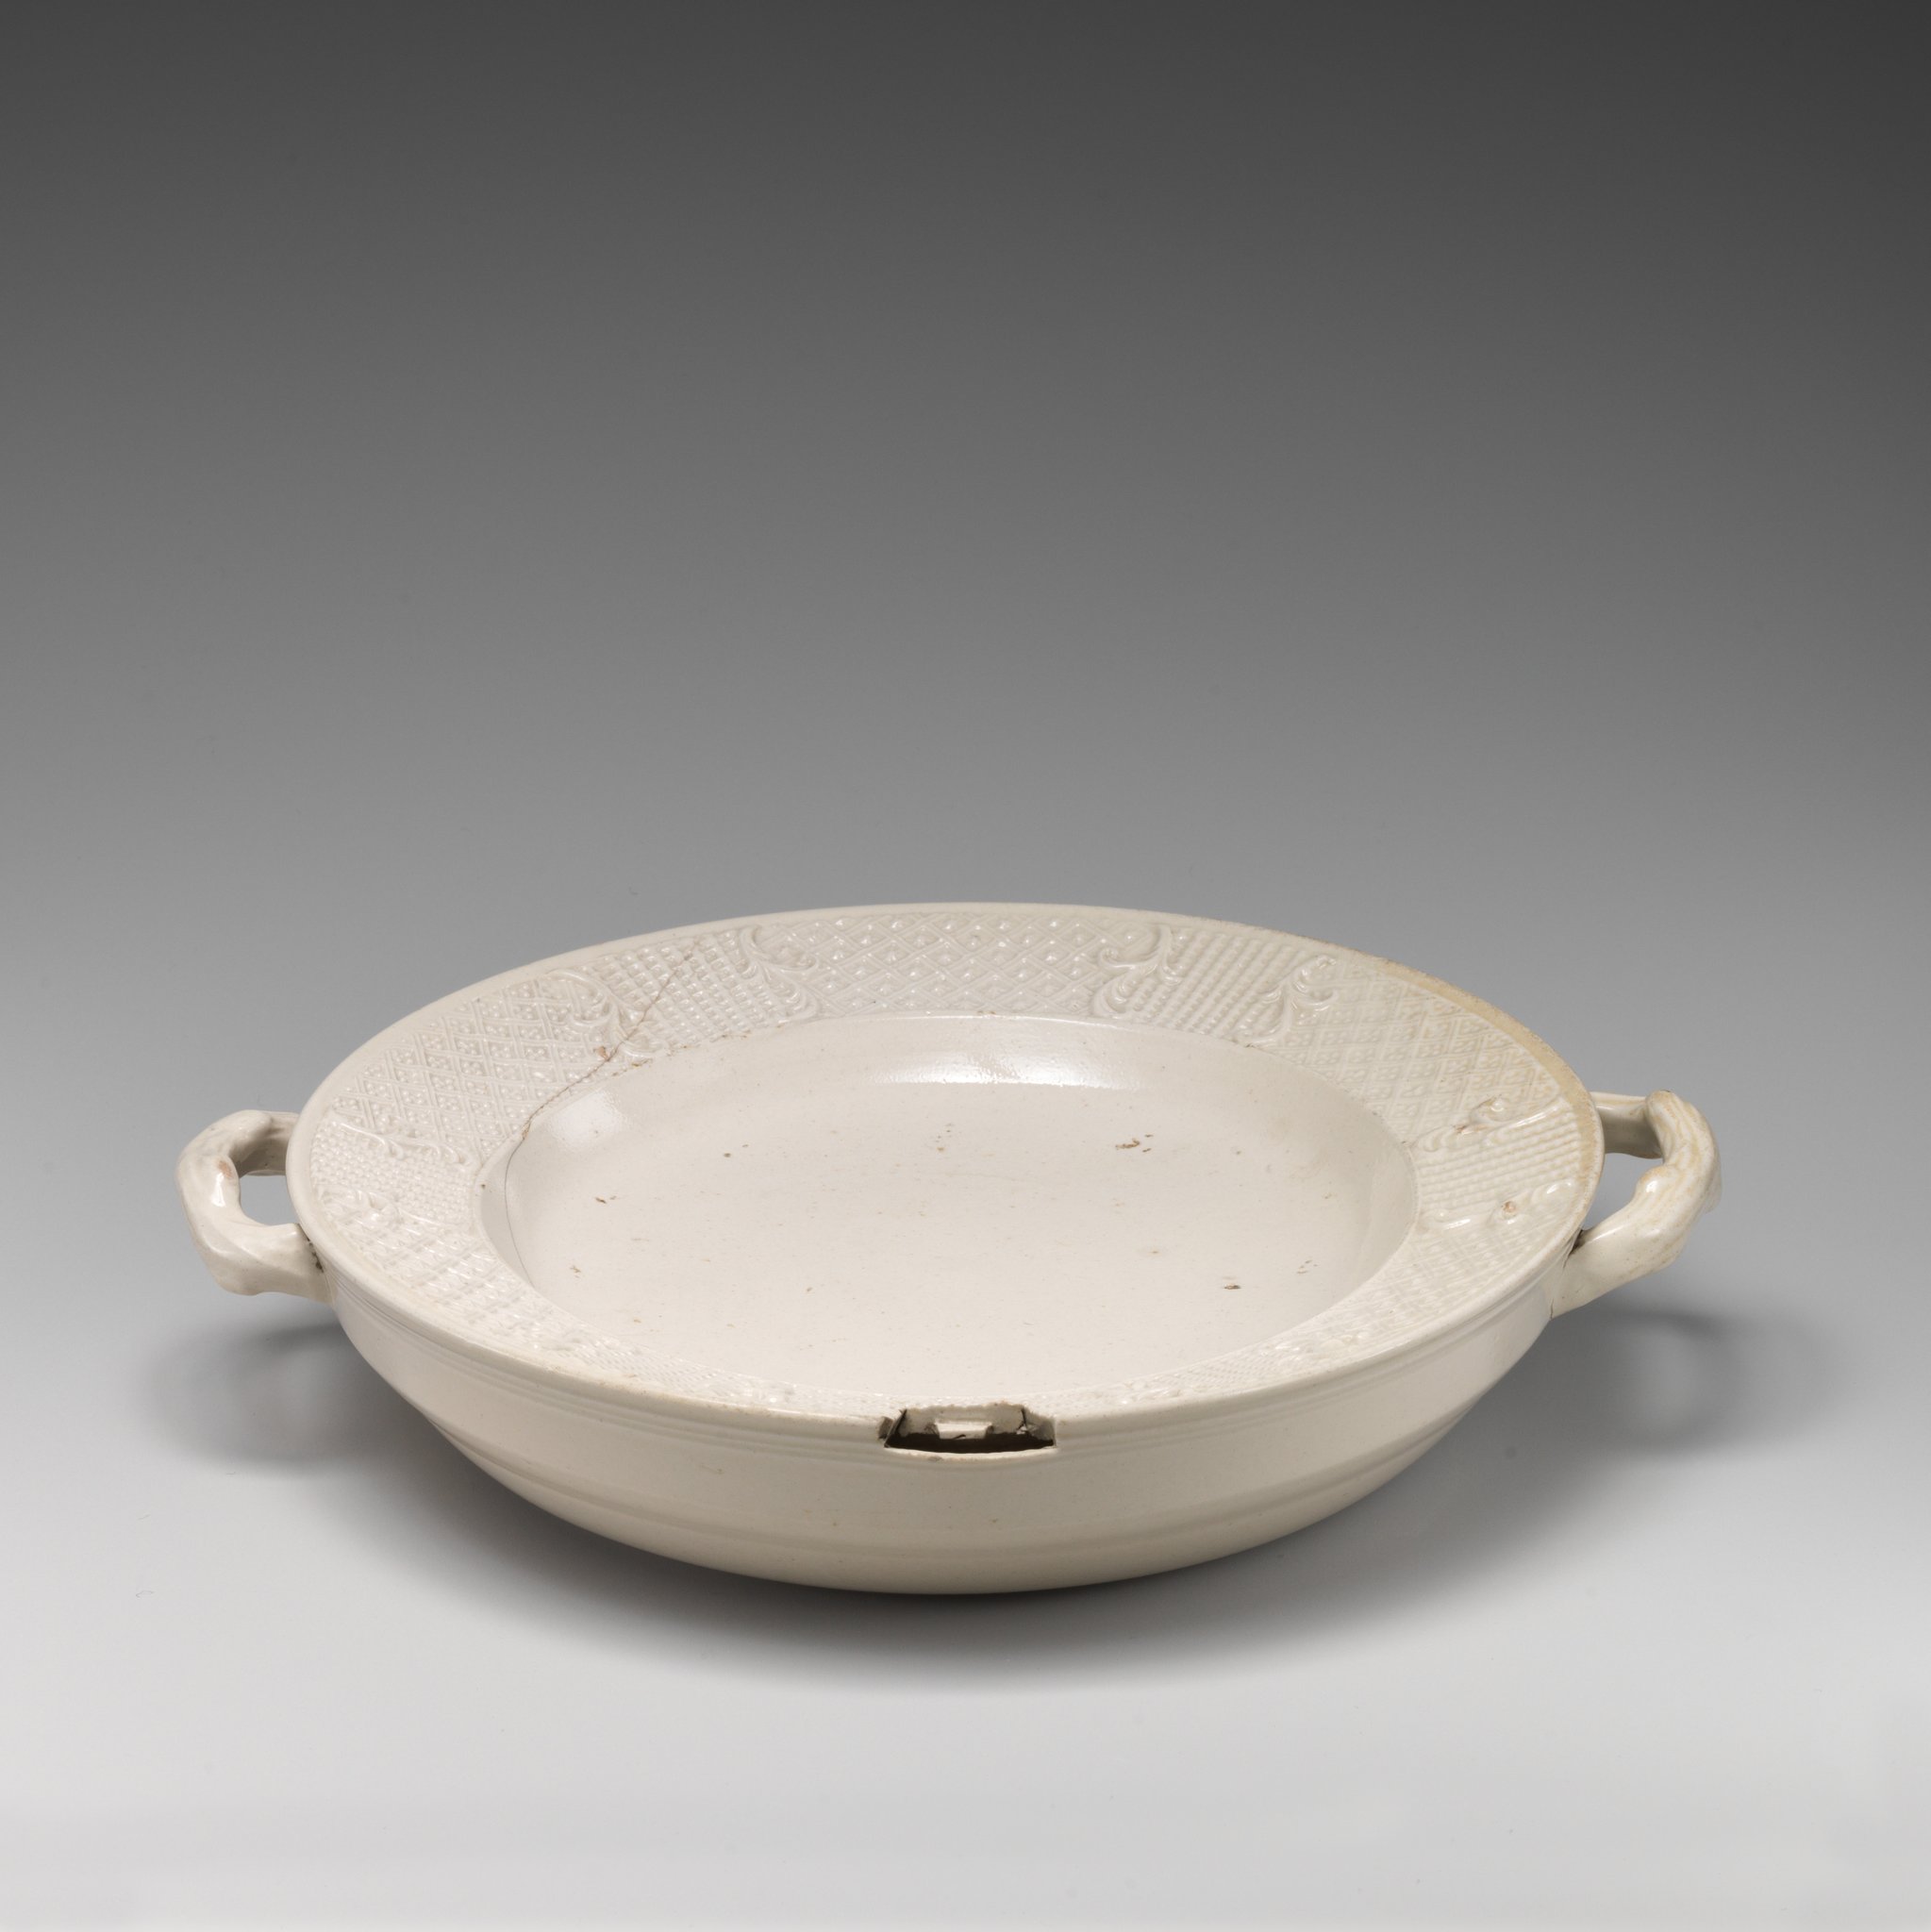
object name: hot water plate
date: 1760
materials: stoneware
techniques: salt glaze